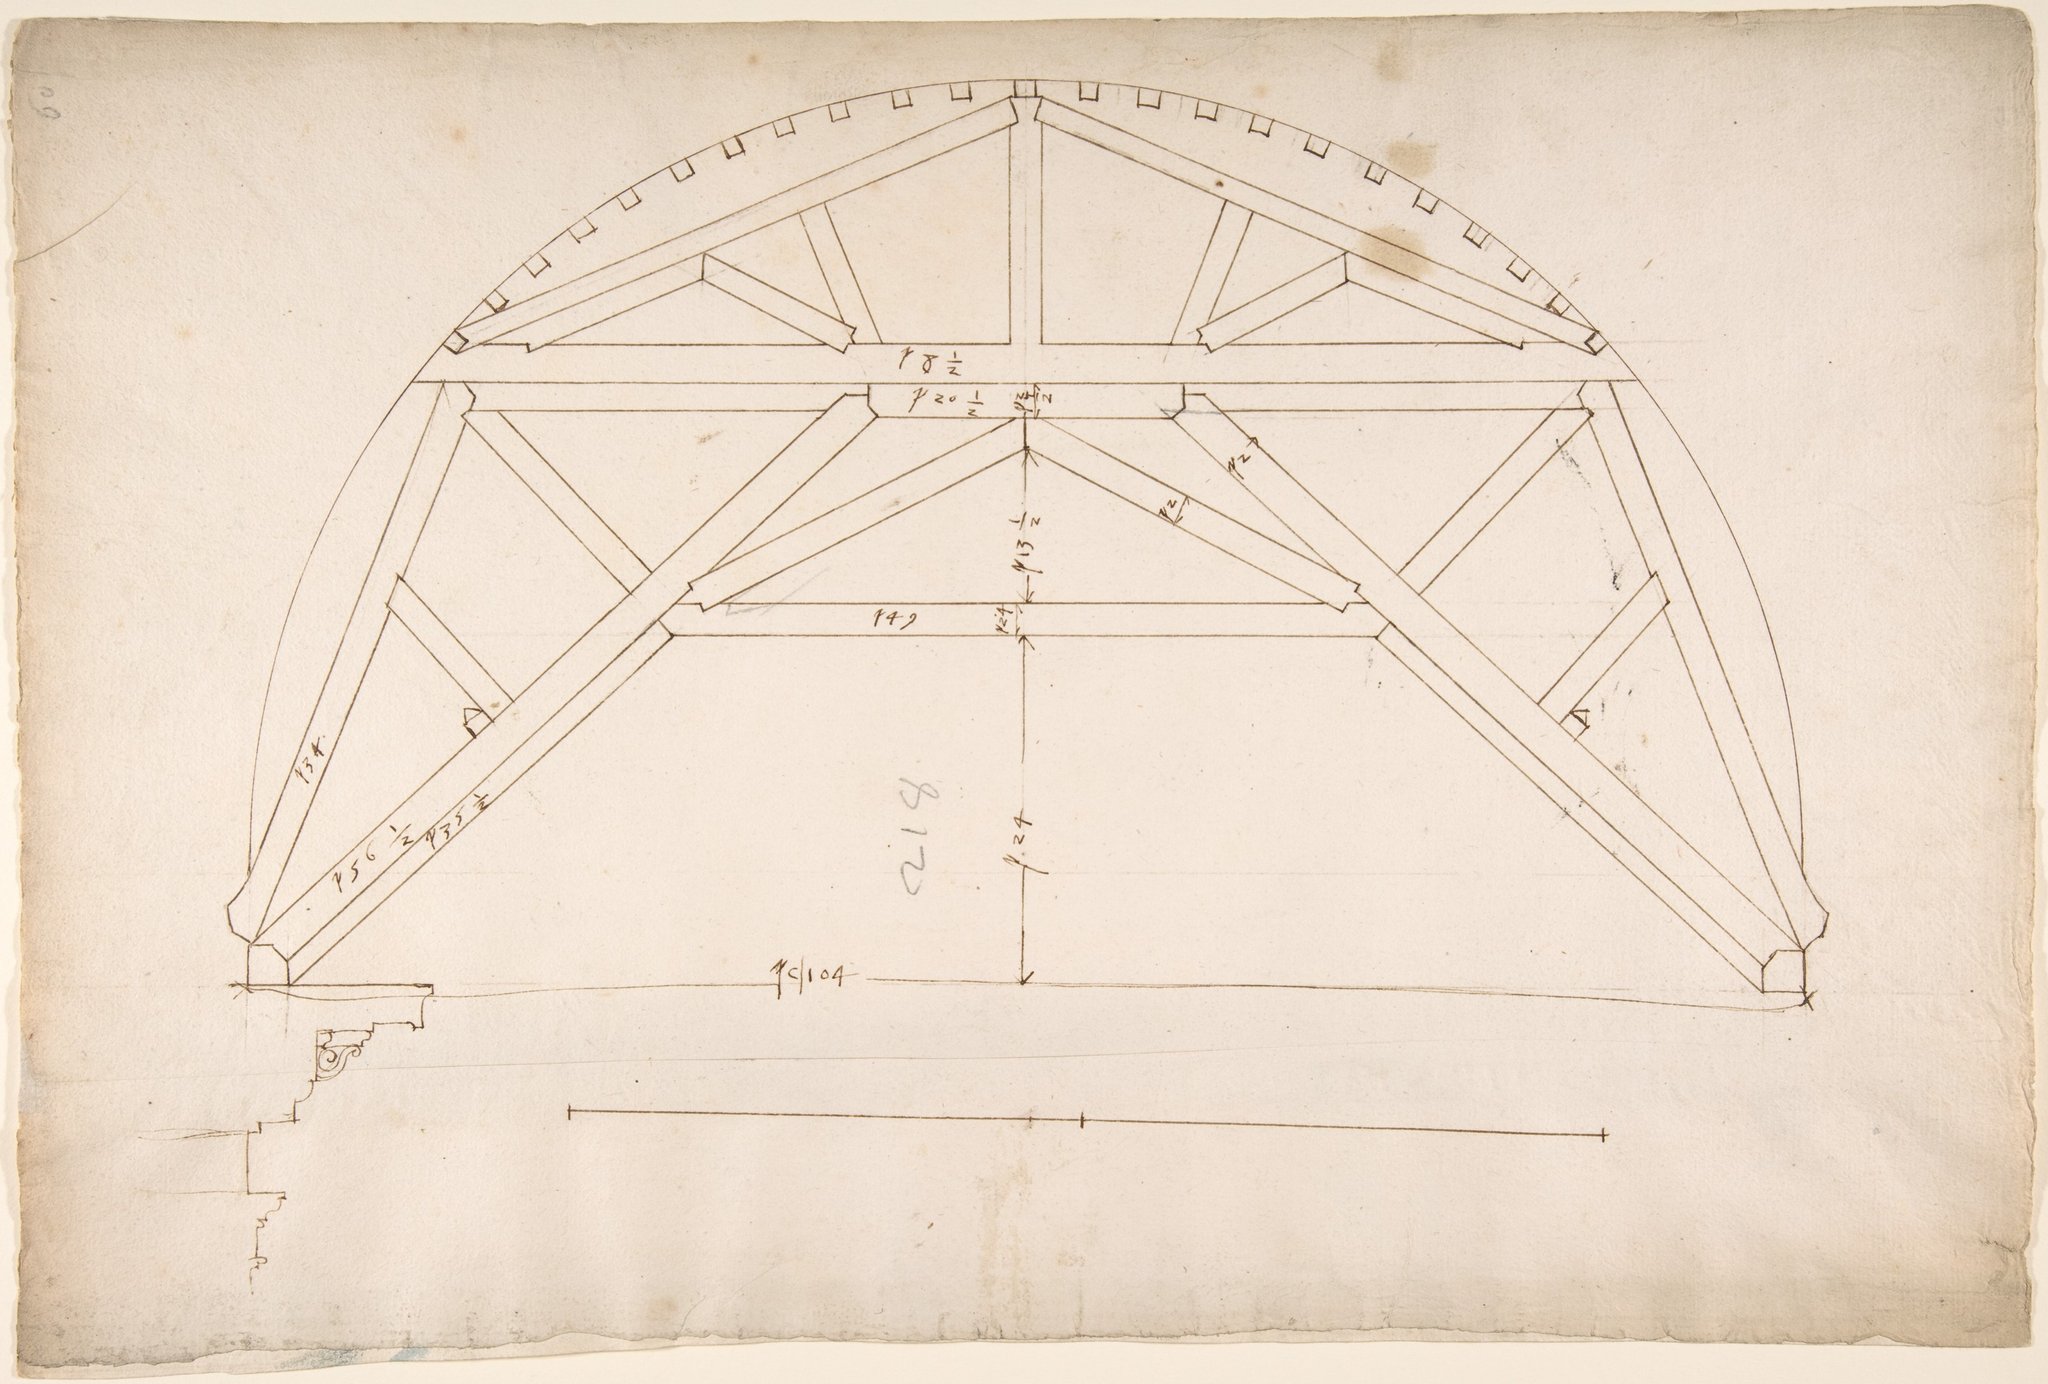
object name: drawing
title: St. Peter's, centering truss, tunnel vault, section (recto) blank (verso)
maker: anonymous, french, 16th century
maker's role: draftsman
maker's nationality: french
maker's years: 1500-1600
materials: chalk, ink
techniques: incising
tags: architecture